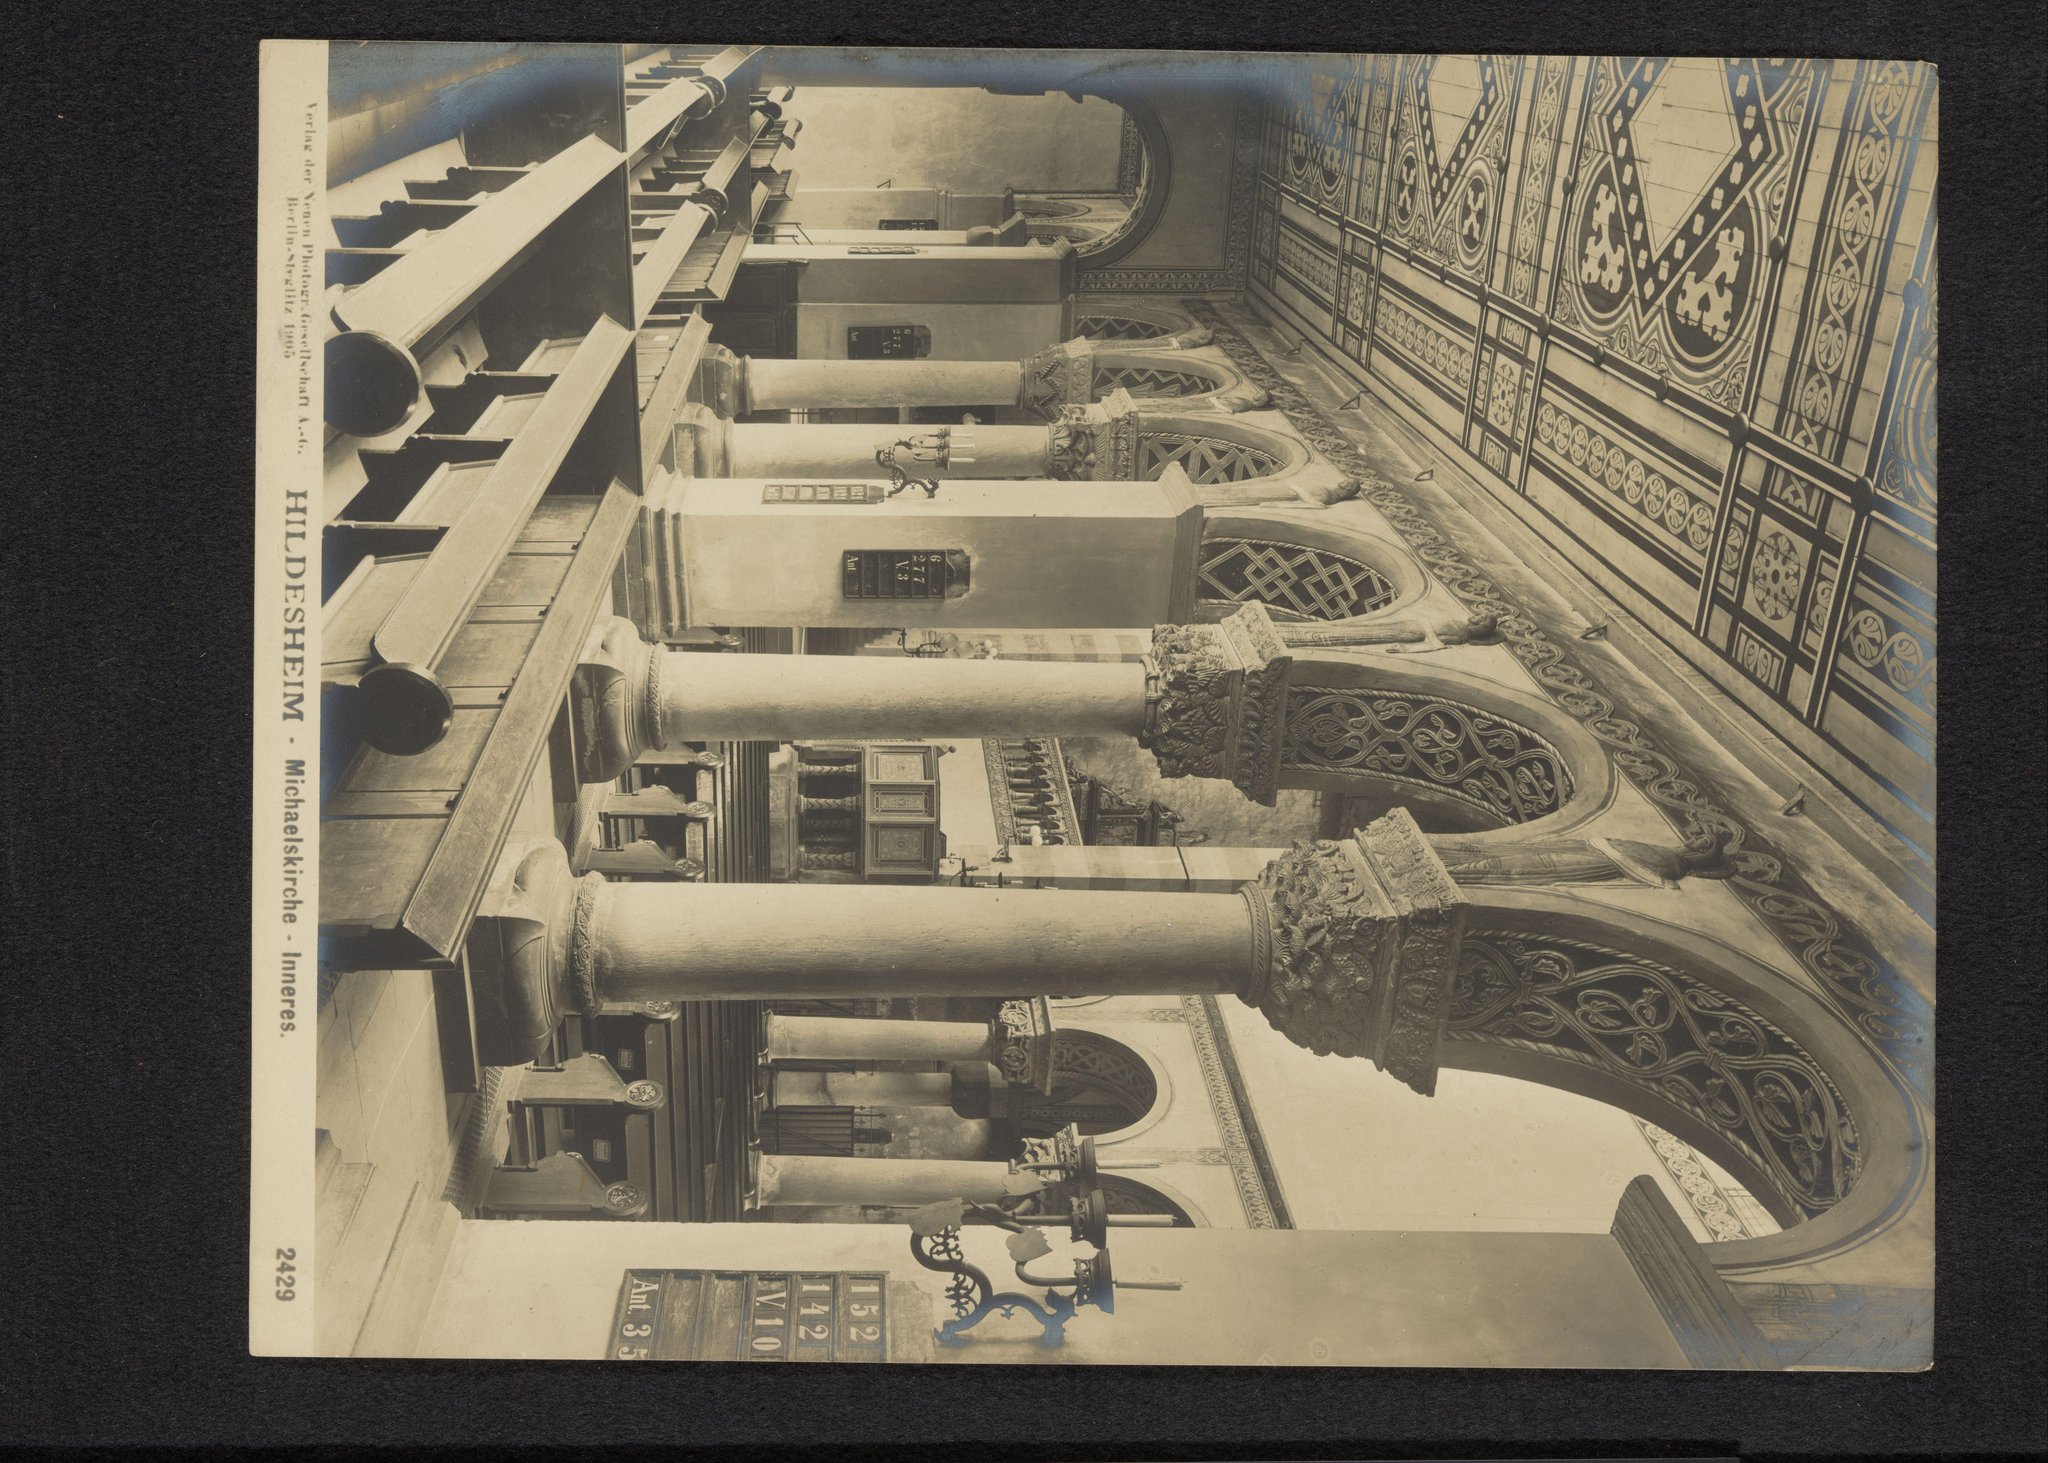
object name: photograph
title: Hildesheim. Michaelskirche-Inneres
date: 1900-1911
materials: photographic support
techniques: gelatin silver print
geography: hildesheim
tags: interior of church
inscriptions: number: ‘2429’